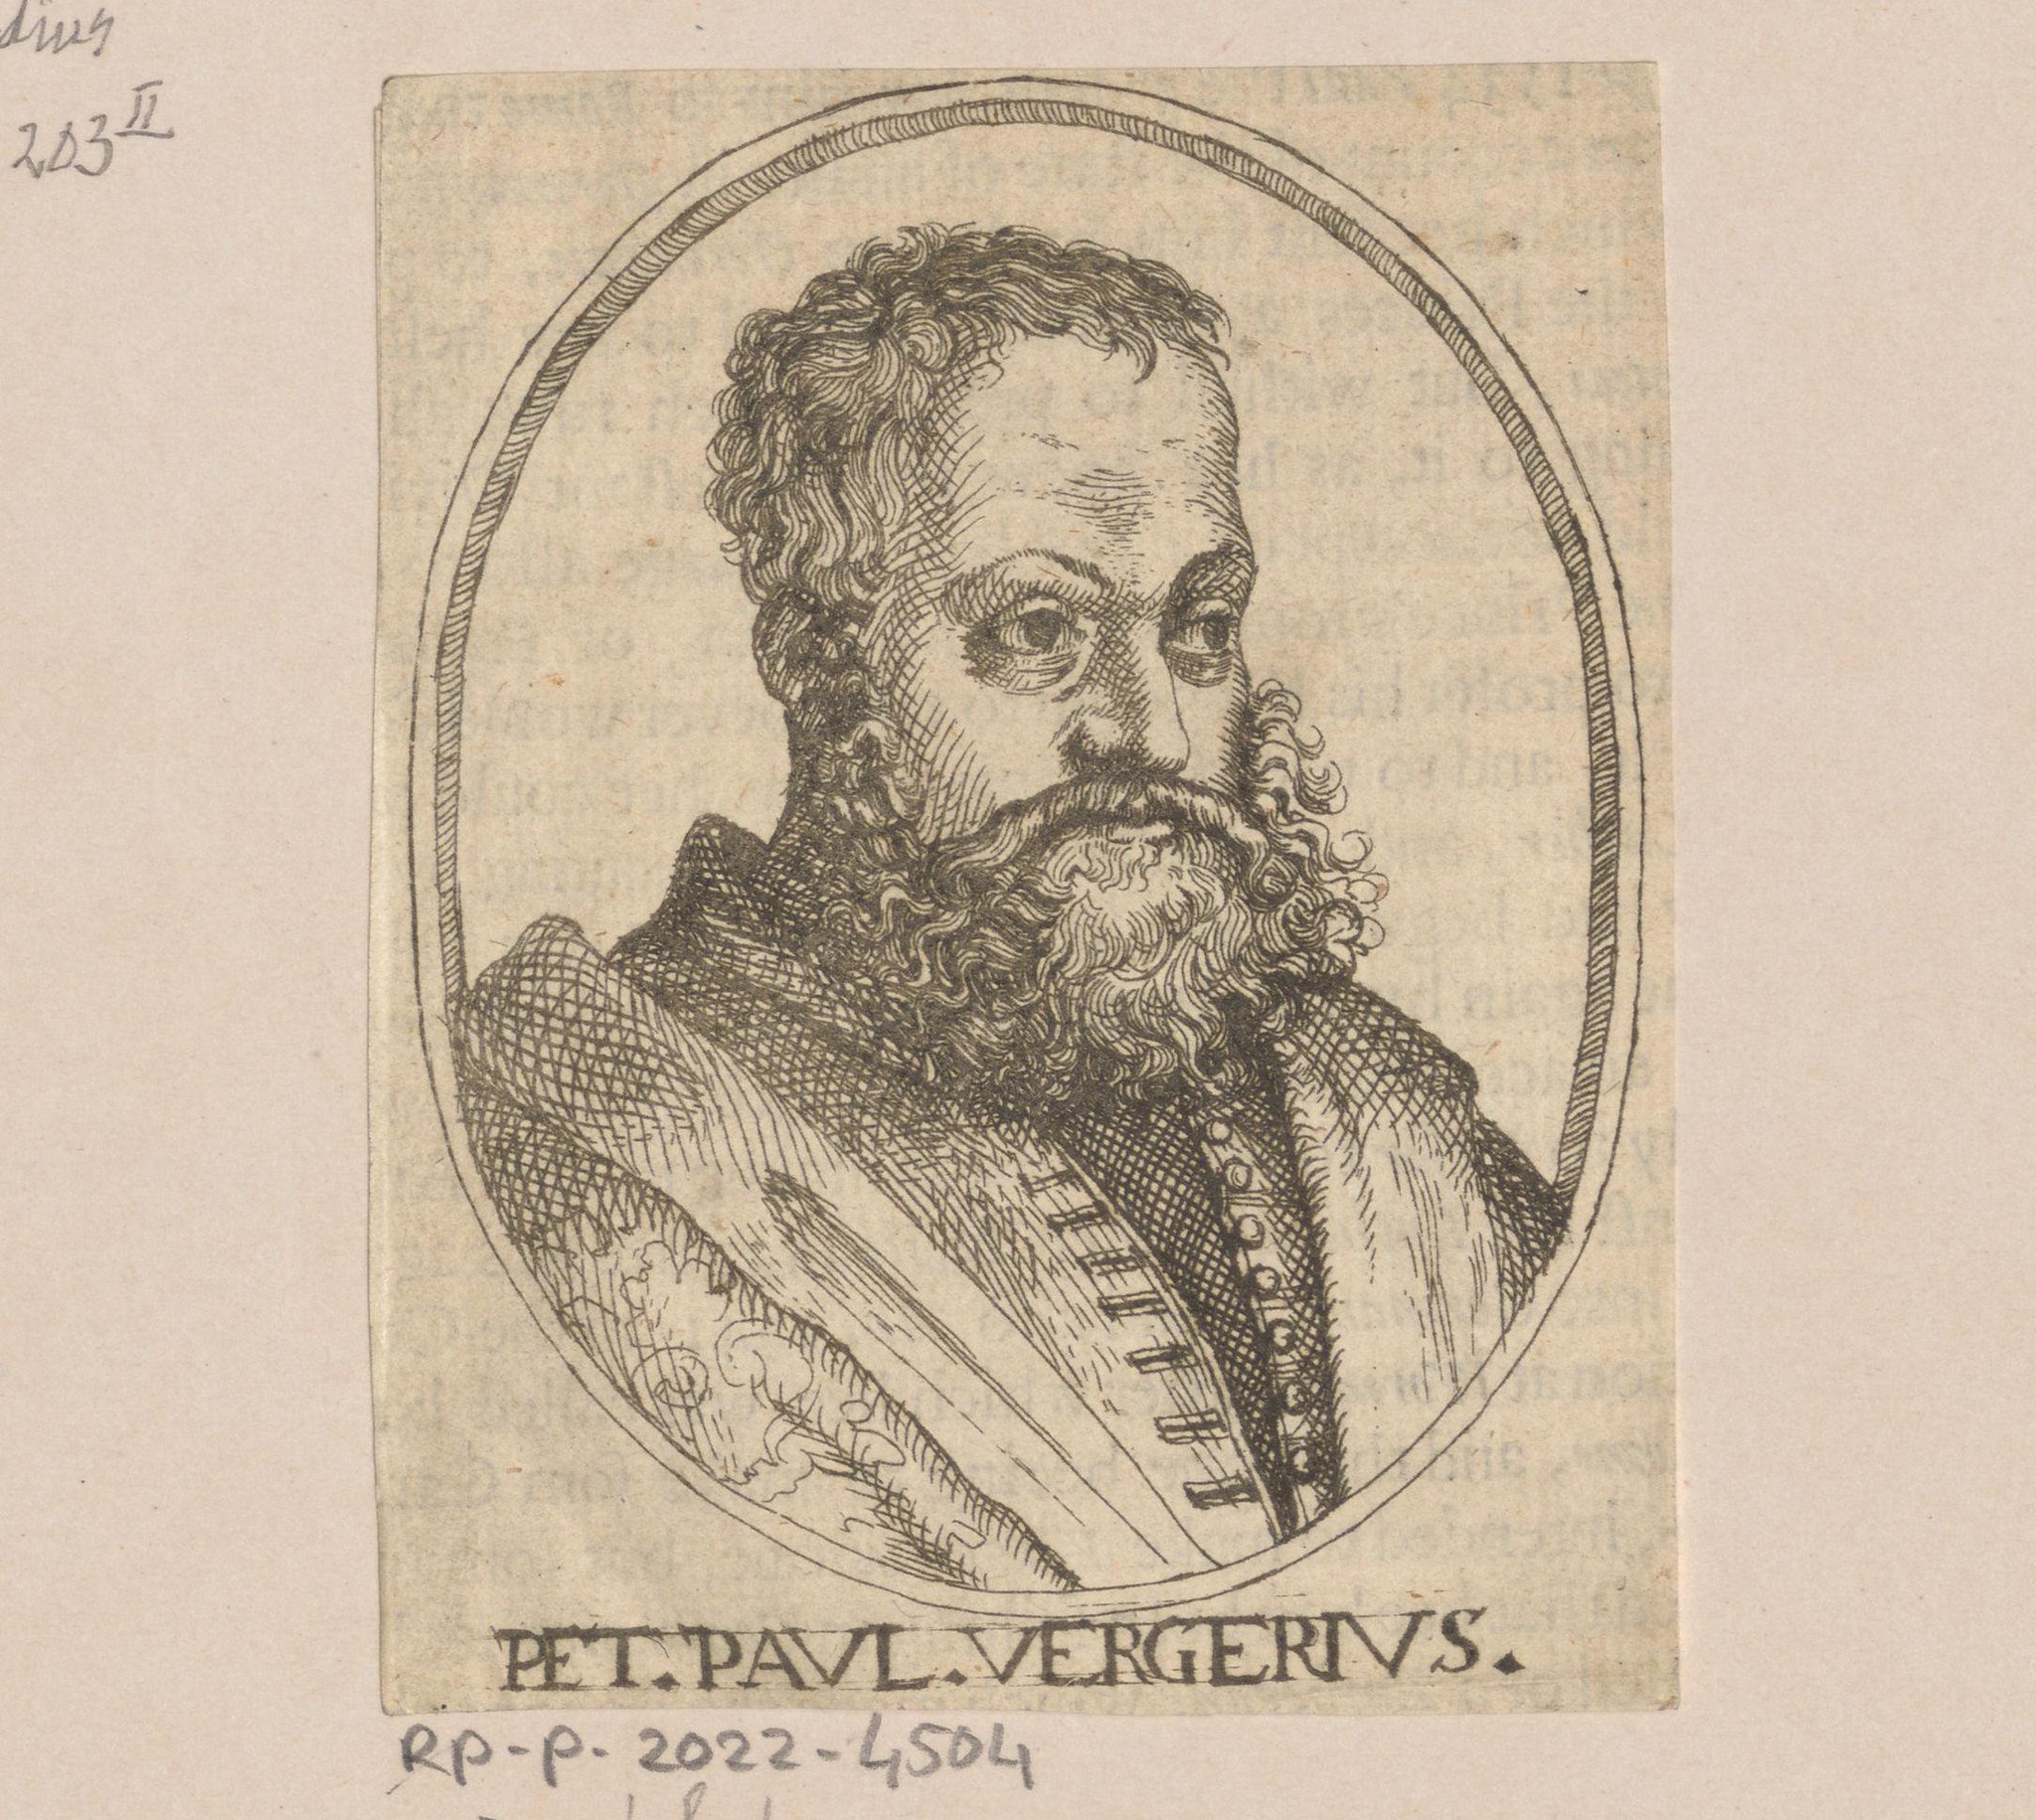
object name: print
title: Portret van Pietro Paolo Vergerio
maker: Anonymous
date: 1654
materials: paper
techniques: etching, letterpress printing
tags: archbishop, bishop, etc. (roman catholic), historical persons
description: Prent uit: Clark, Samuel. The Marrow of Ecclesiastical History. Londen: William Roybould, 1654, p. 676.